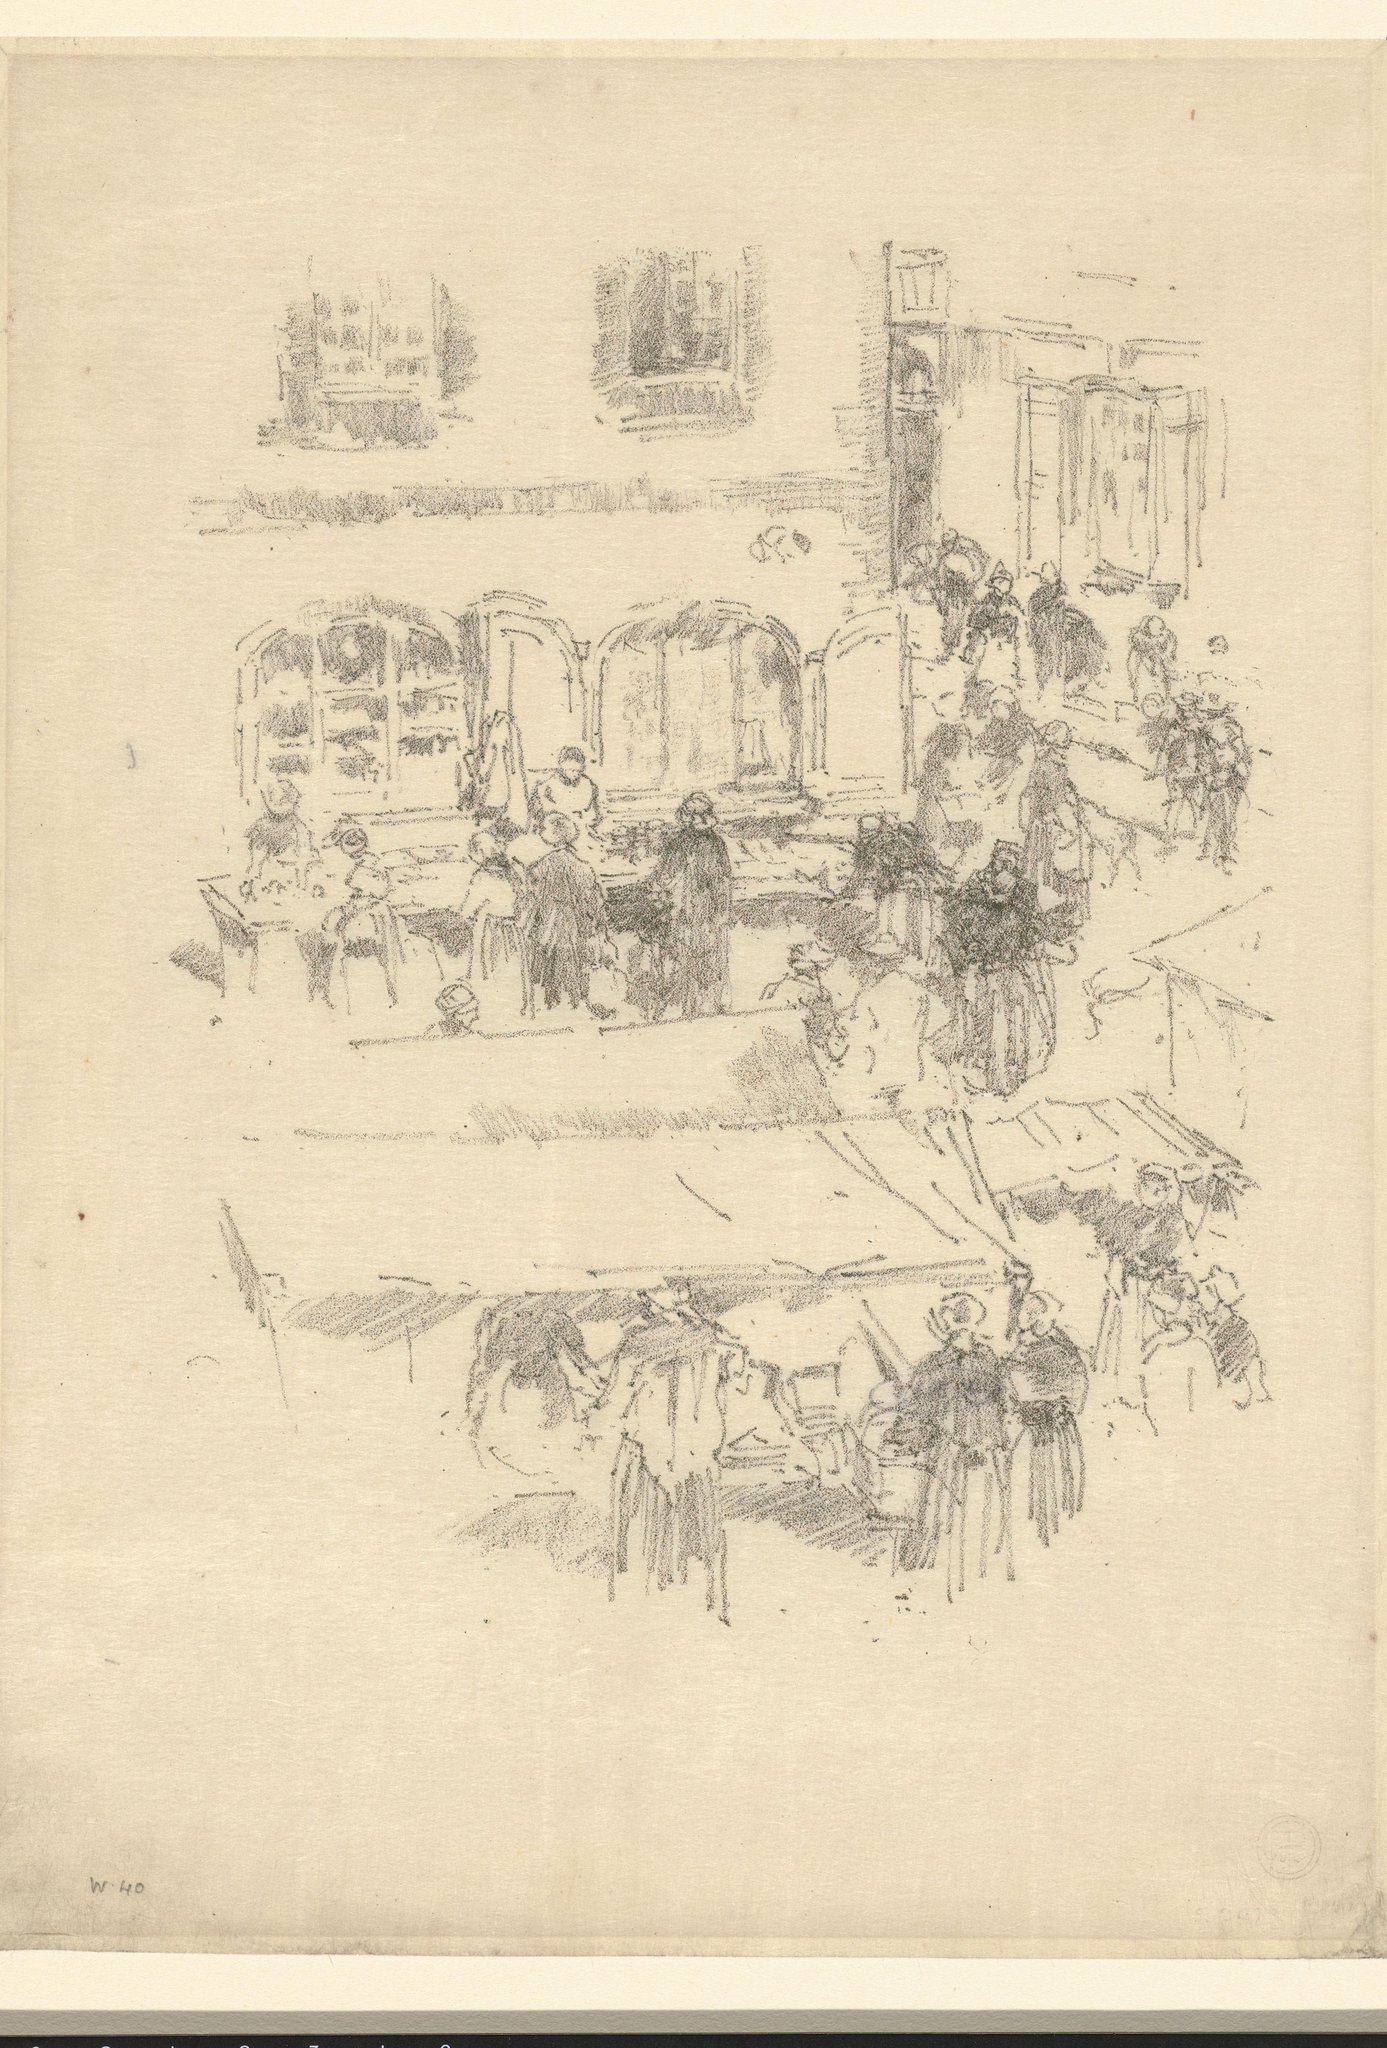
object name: print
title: The Market-Place, Vitré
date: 1893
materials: paper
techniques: lithograph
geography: london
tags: market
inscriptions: collector's mark: Lugt 2228, collector's mark: Lugt 405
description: Gezicht op een marktplein in Vitré, Bretange. Tussen de marktkramen lopen vele vrouwen, in klederdracht.